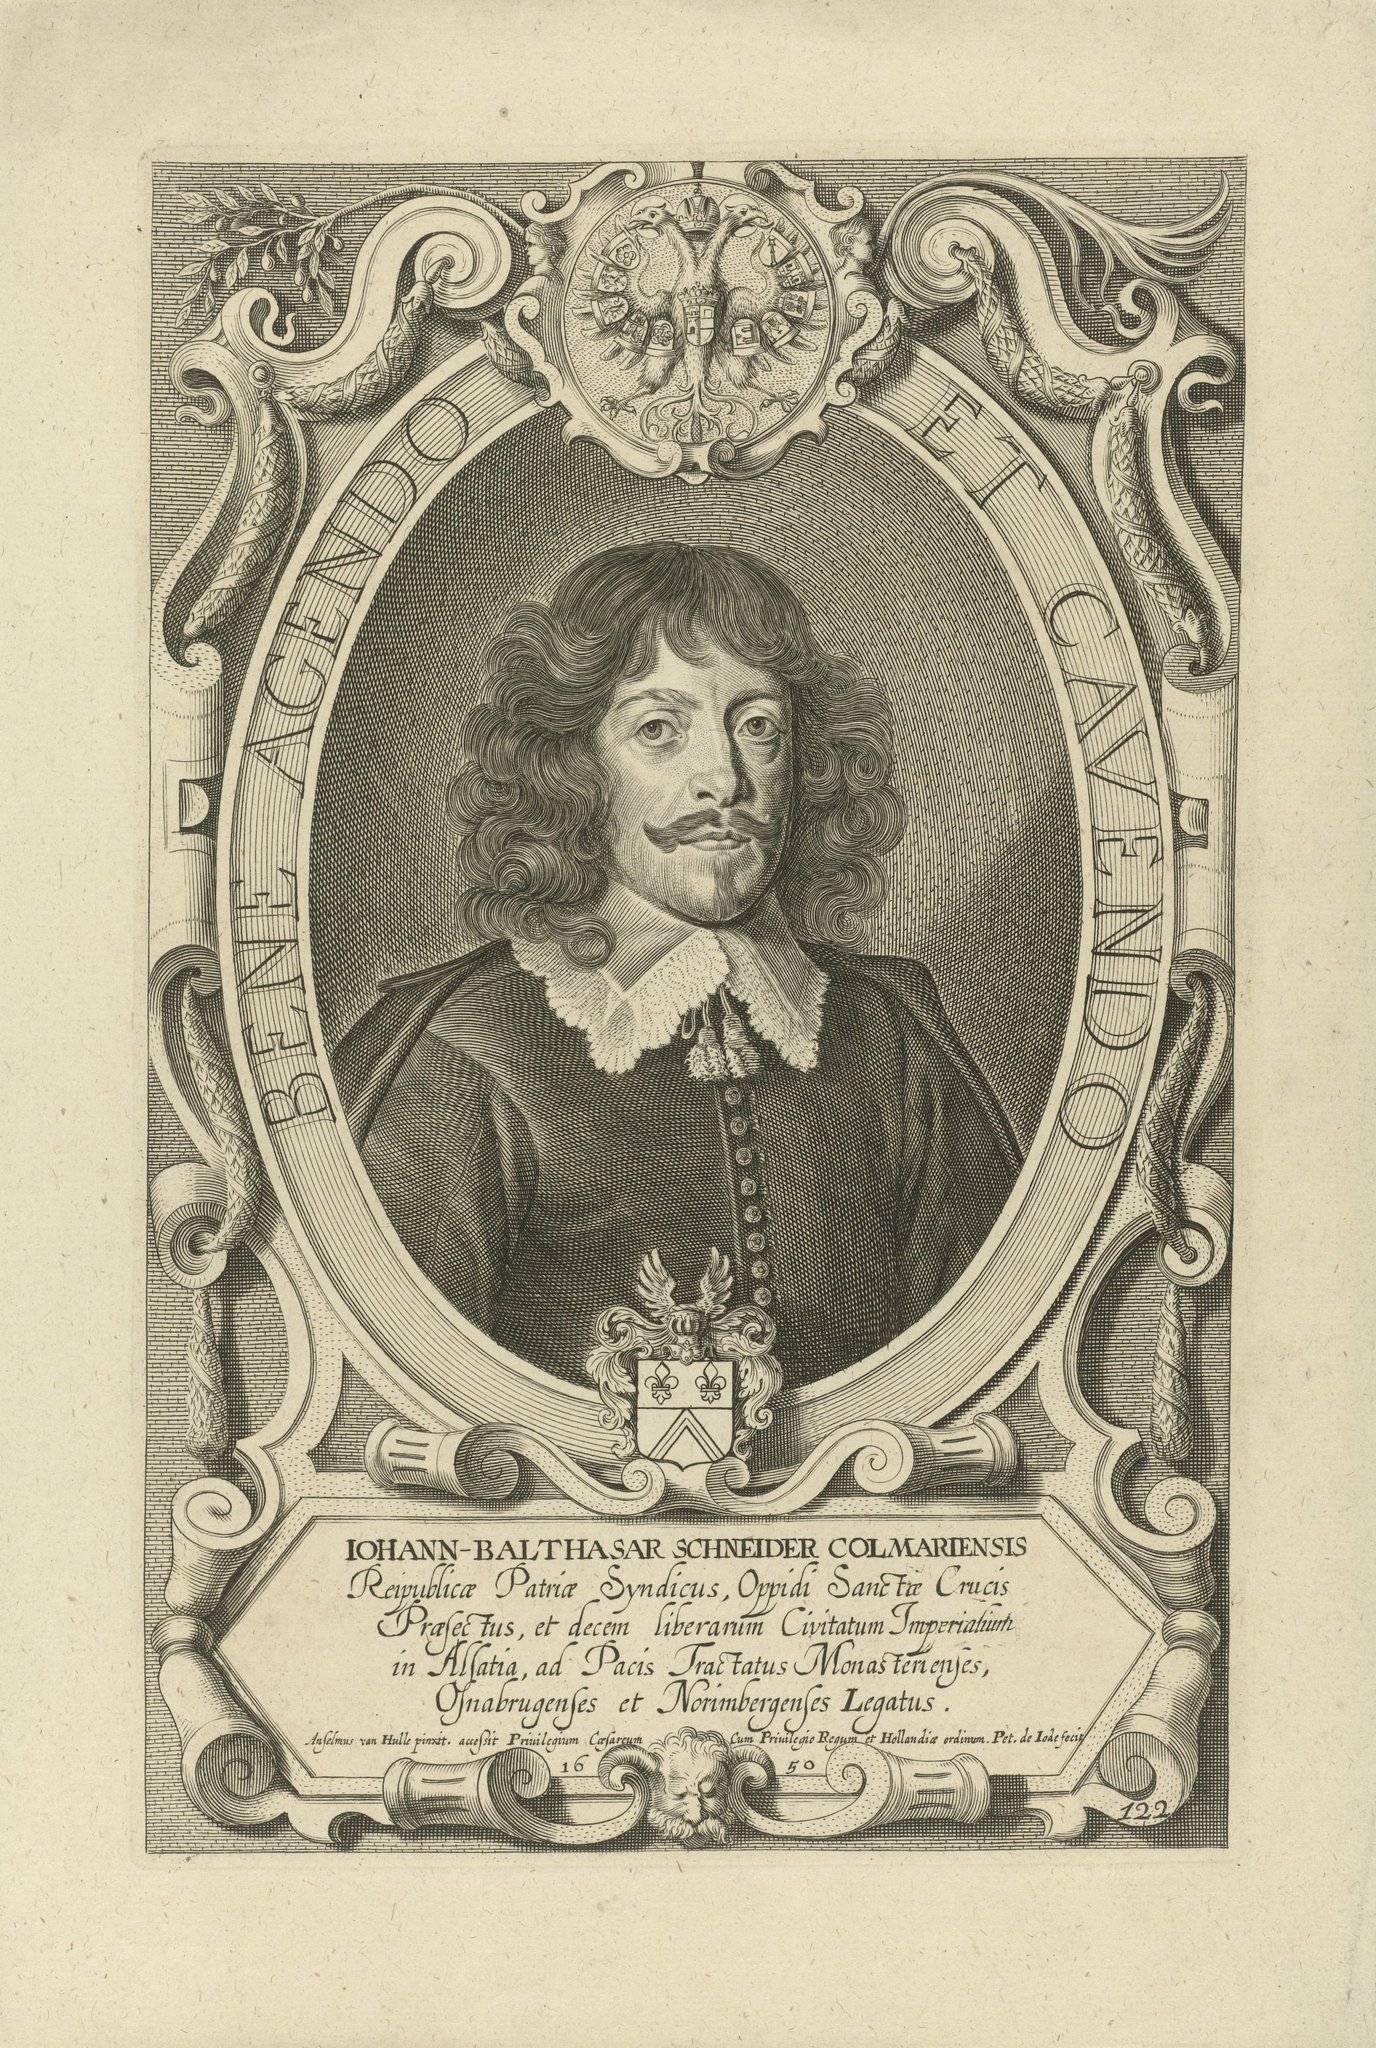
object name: print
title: Portret van Johann-Balthasar Schneider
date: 1650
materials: paper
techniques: engraving, etching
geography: antwerp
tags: colmar, prefect, syndicus, johann balthasar schneider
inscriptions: collector's mark: Lugt 2228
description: Busteportret van Johann-Balthasar Schneider. Rechtsonder: 122. Het portret is gevat in een ovale omlijsting met het wapenschild van de geportretteerde, decoraties en een randschrift in het Latijn. In de cartouche een vijfregelig onderschrift in het Latijn. Prent uit een serie portretten naar schilderijen van Anselmus van Hulle van alle gedelegeerden bij de vredesonderhandelingen te Münster en Osnabrück.